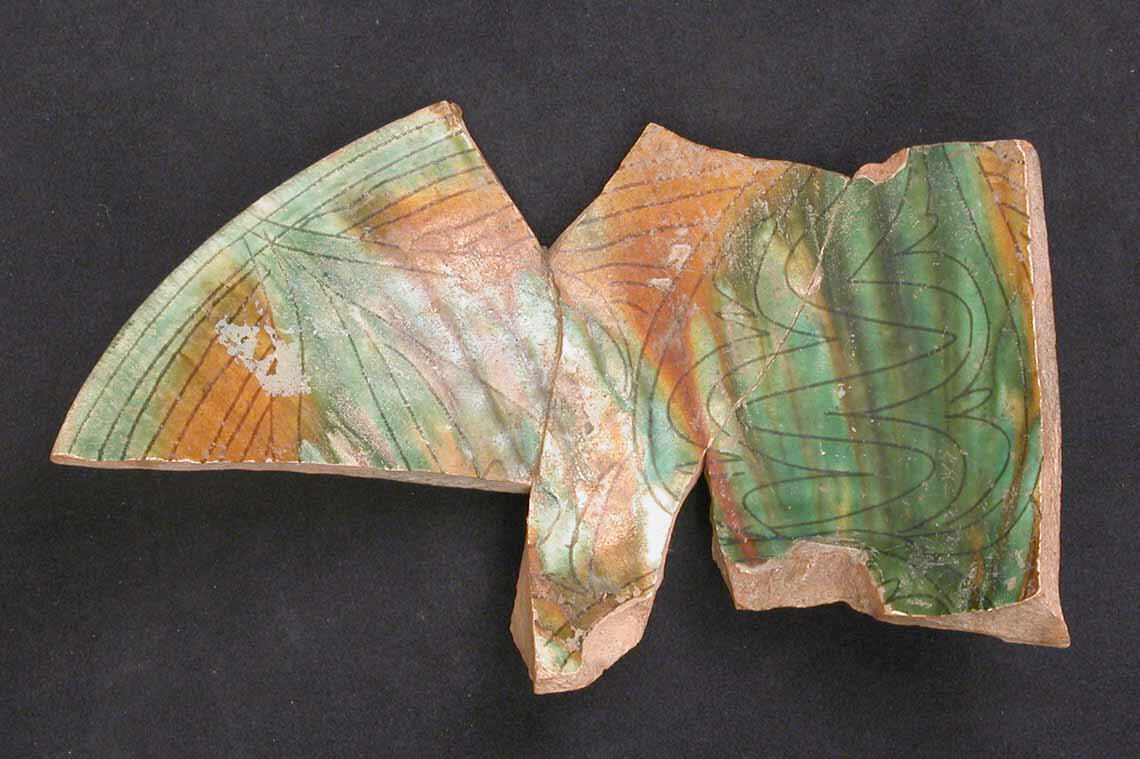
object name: fragment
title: Fragment of a Bowl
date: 801-1000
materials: earthenware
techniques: glazing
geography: iran